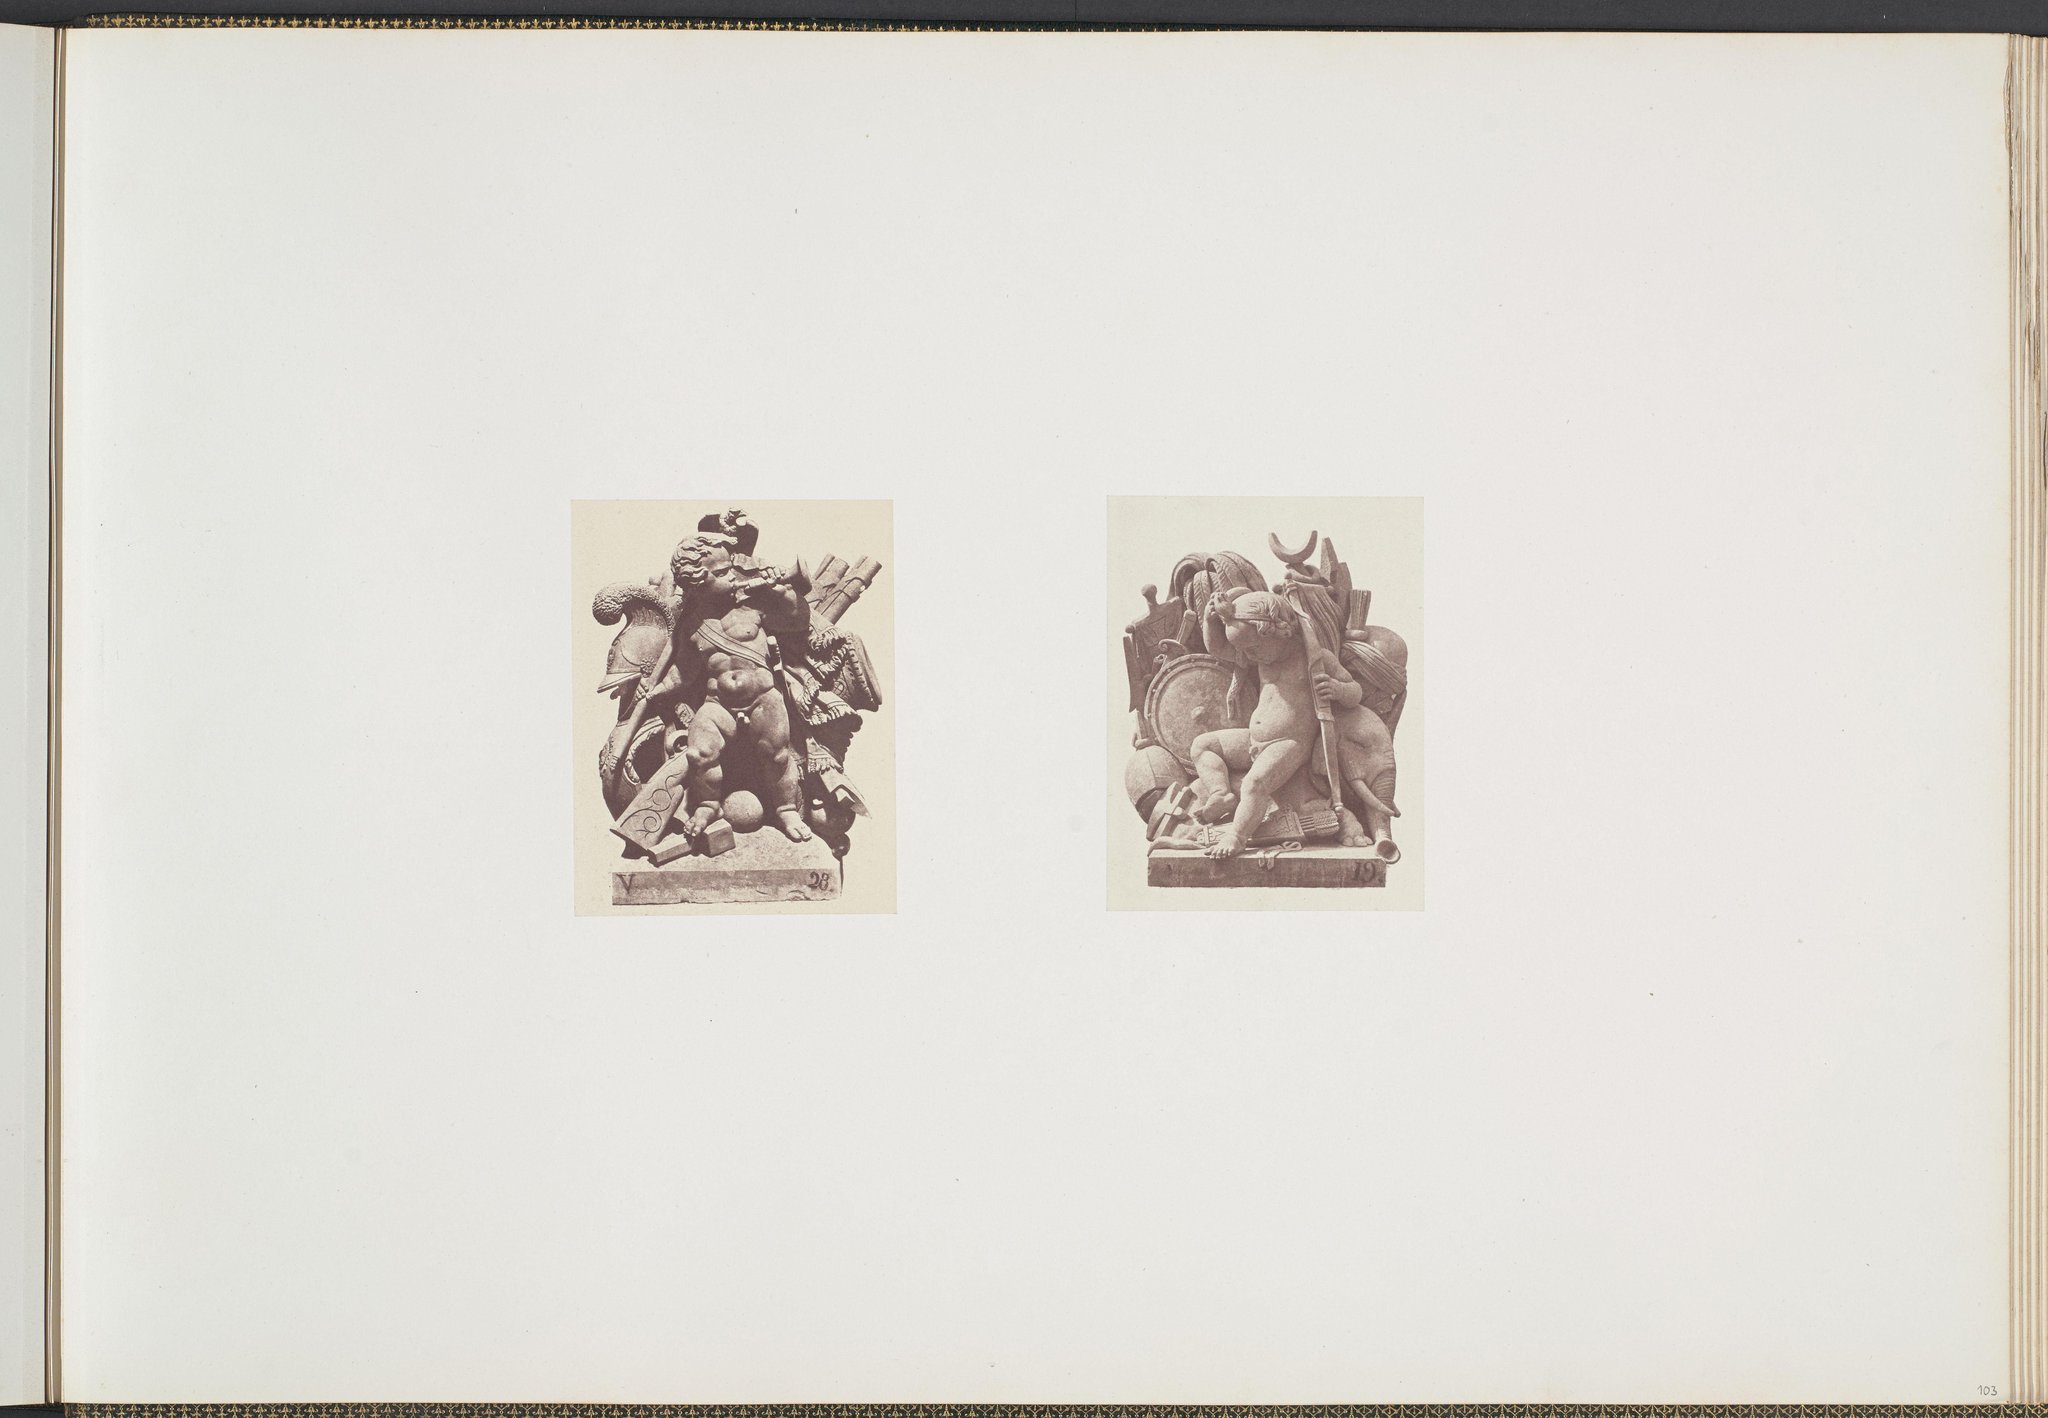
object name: album leaf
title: Gipsmodellen voor beeldhouwwerken op het Palais du Louvre: links "Le Guerre" door Democrito Gandolphi en rechts "L'Asie" door Carl Elshoecht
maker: édouard denis baldus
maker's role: fotograaf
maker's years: 1813-1889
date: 1855-1857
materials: paper, photographic support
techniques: salted paper print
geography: paris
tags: piece of sculpture, reproduction of a piece of sculpture, permanent exhibition, museum, paris, tuileries palace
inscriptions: number: ‘V 28 en V 19’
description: Onderdeel van Réunion des Tuileries au Louvre 1852-1857, album 2.